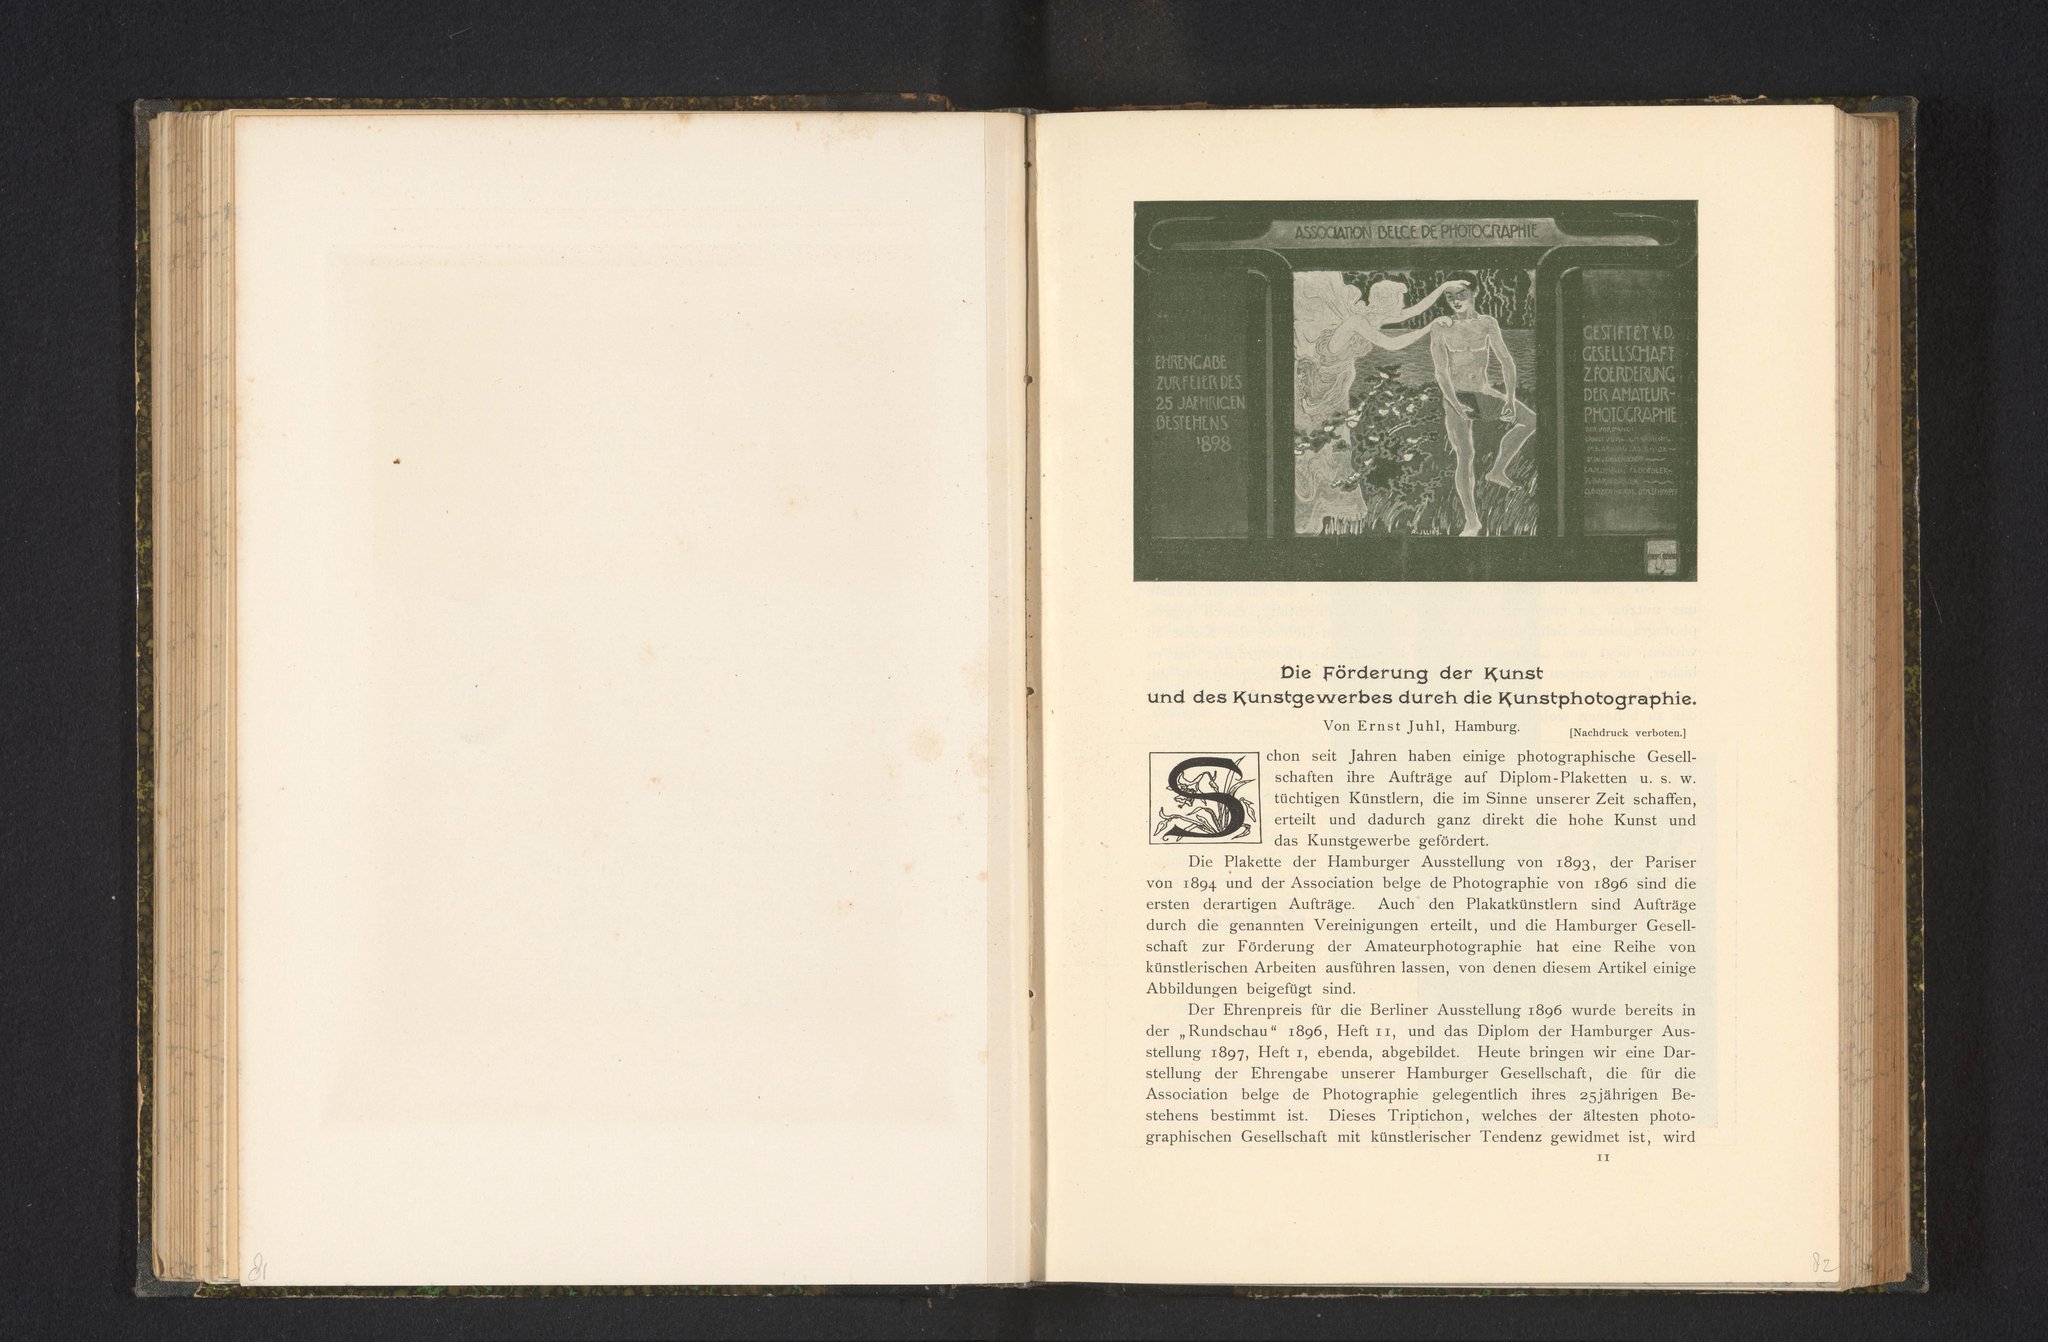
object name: photomechanical print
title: Geschenk van de Association Belge de Photographie ter ere van het vijfentwintigjarig bestaan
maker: Anonymous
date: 1893-1898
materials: paper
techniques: autotype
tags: distribution of awards ~ art contest